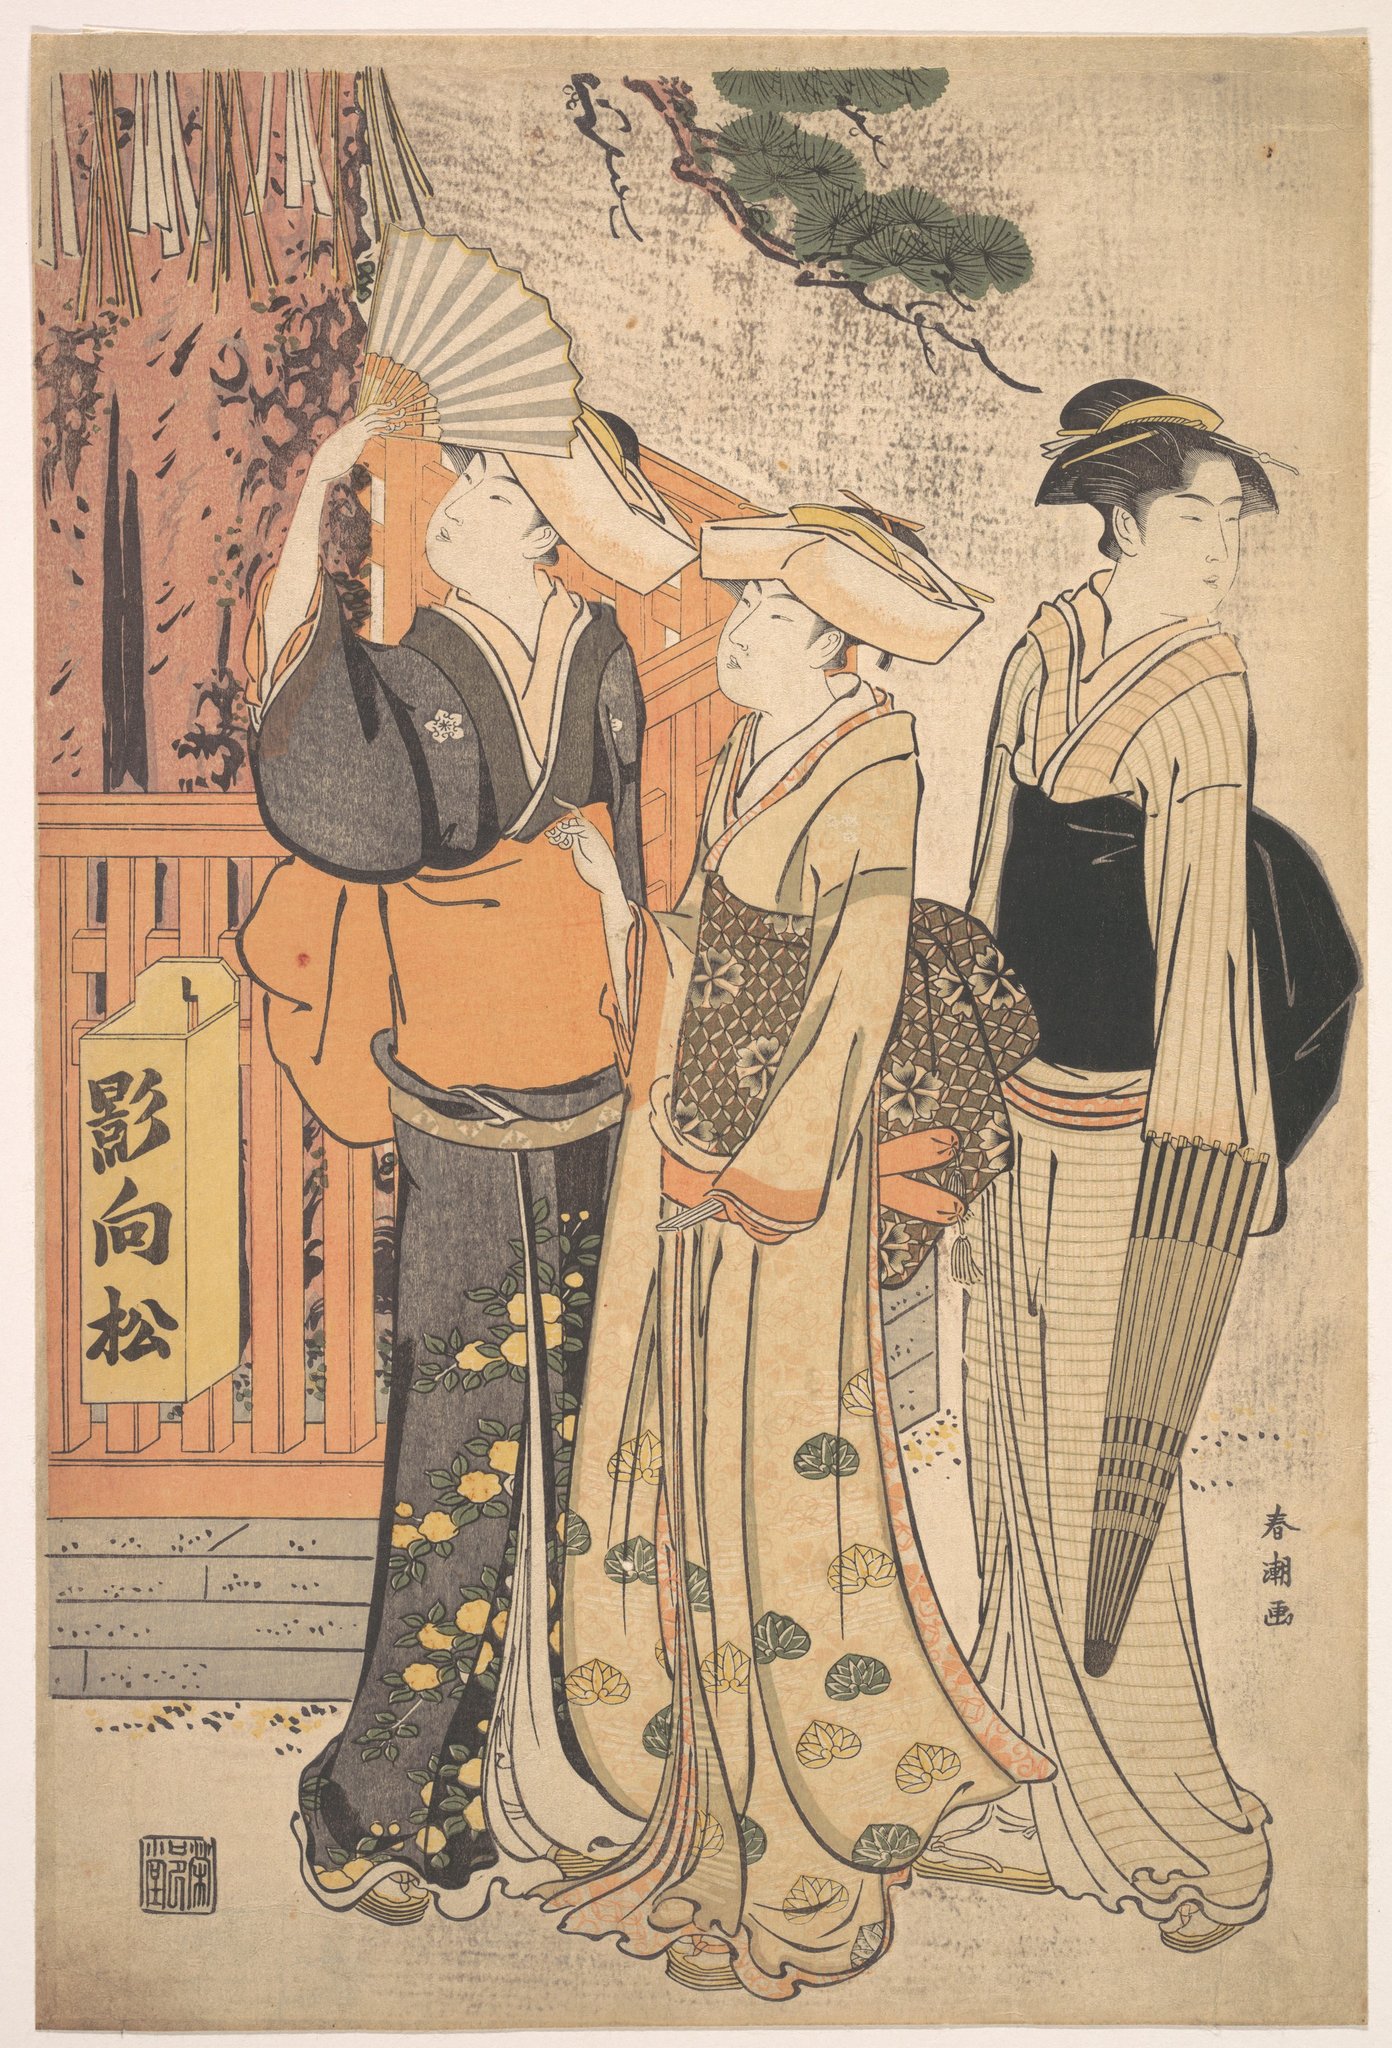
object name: woodblock print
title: Three Women at the Base of a Pine Tree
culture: japanese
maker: katsukawa shunchō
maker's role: artist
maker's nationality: japanese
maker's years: 1775-1795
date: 1790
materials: ink, paper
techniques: woodblock print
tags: fans,women